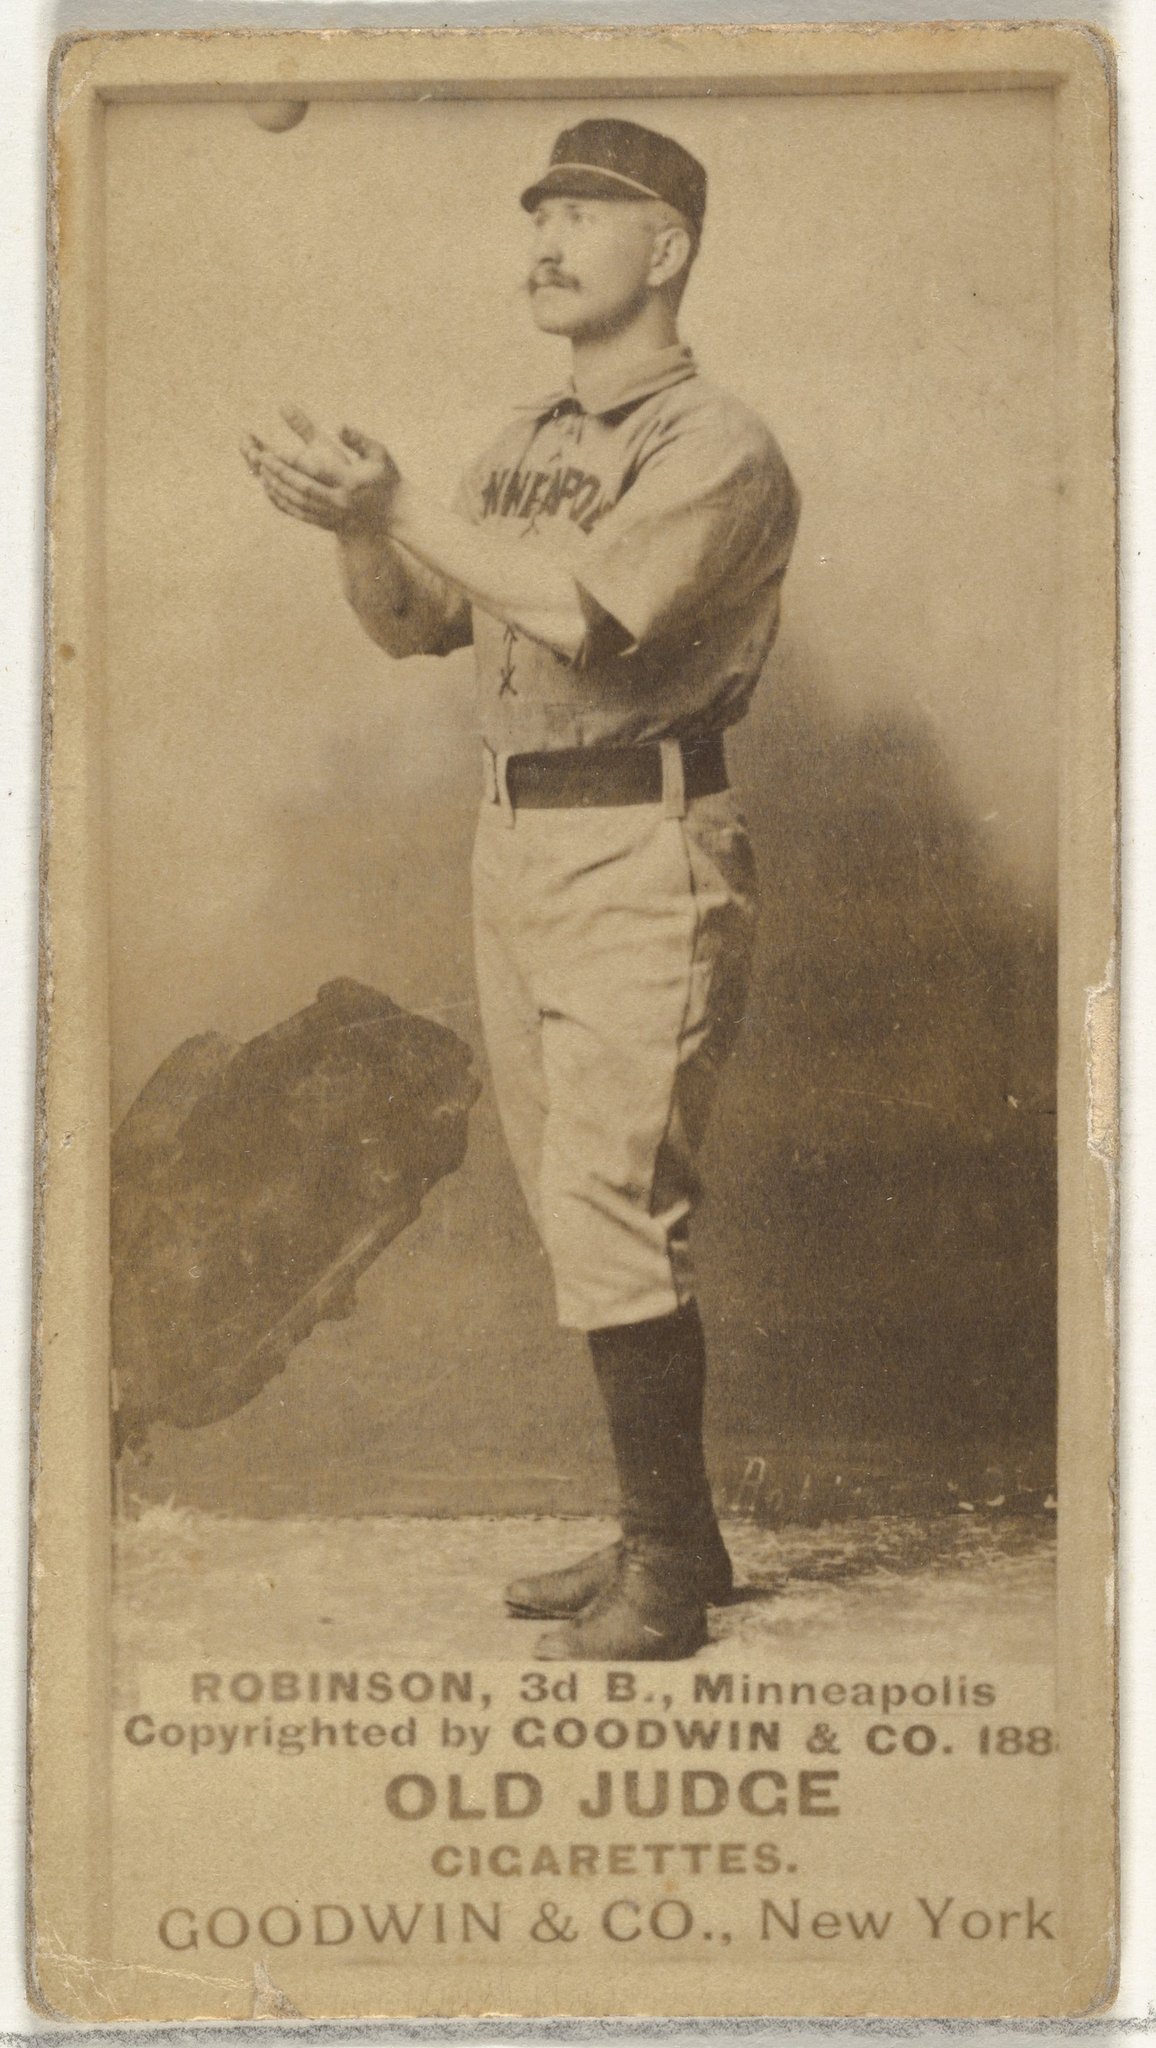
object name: baseball card, photograph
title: Myers C. Robinson, 3rd Base, Minneapolis, from the Old Judge series (N172) for Old Judge Cigarettes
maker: goodwin & company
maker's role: publisher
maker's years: 1850-1950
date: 1888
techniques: albumen silver print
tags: men,portraits,baseball,athletes